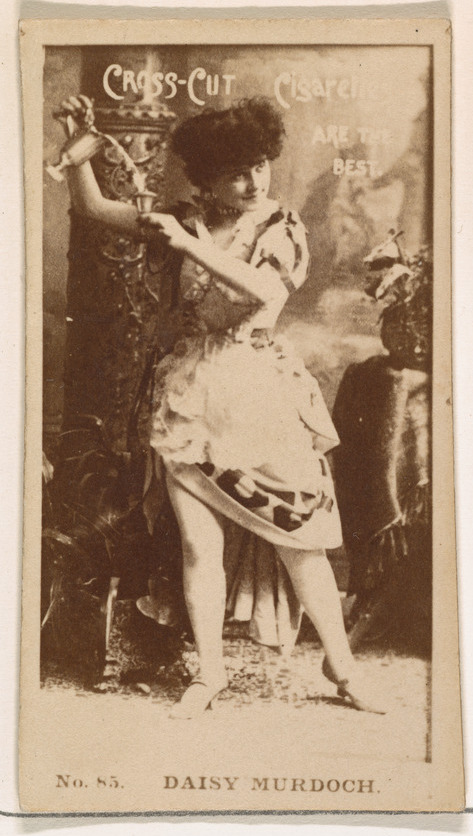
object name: print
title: Card Number 85, Daisy Murdoch, from the Actors and Actresses series (N145-2) issued by Duke Sons & Co. to promote Cross Cut Cigarettes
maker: w. duke, sons & co.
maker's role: publisher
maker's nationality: american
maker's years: 1870-1920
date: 1880-1889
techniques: albumen silver print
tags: portraits,women,actresses